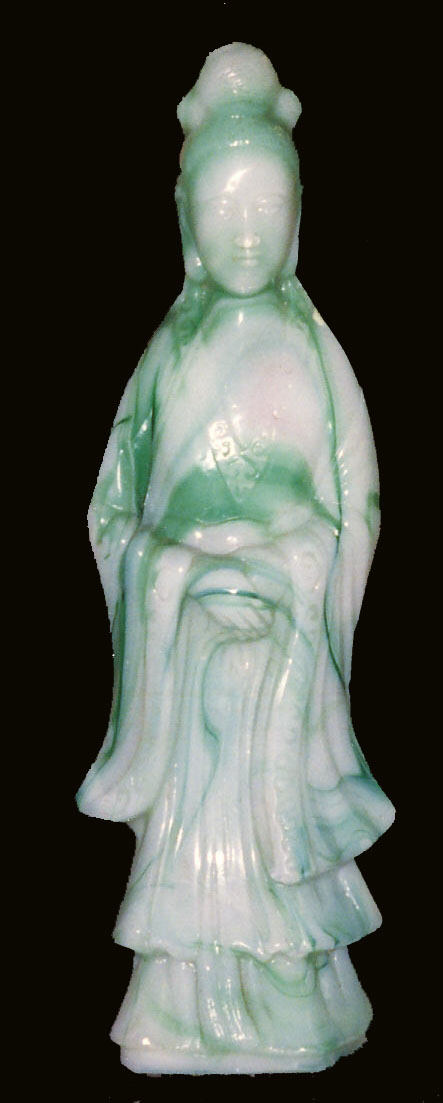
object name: figure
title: Statuette of a Female Figure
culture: chinese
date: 1901-2000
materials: glass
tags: women